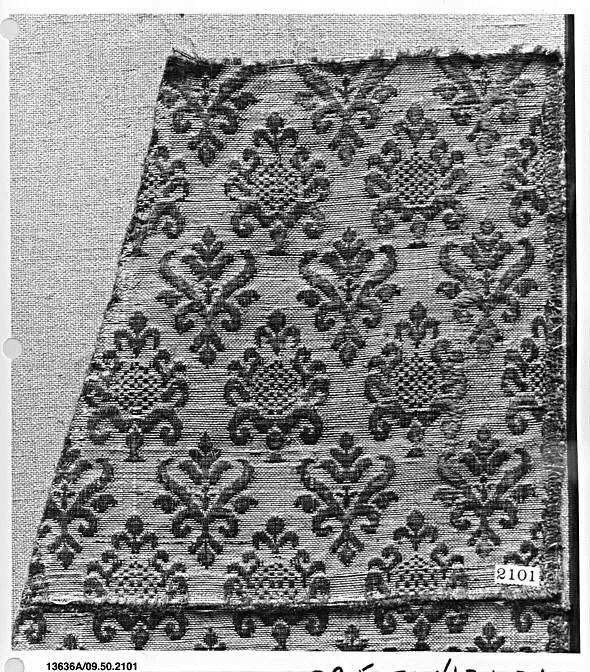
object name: piece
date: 1501-1600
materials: hemp, silk